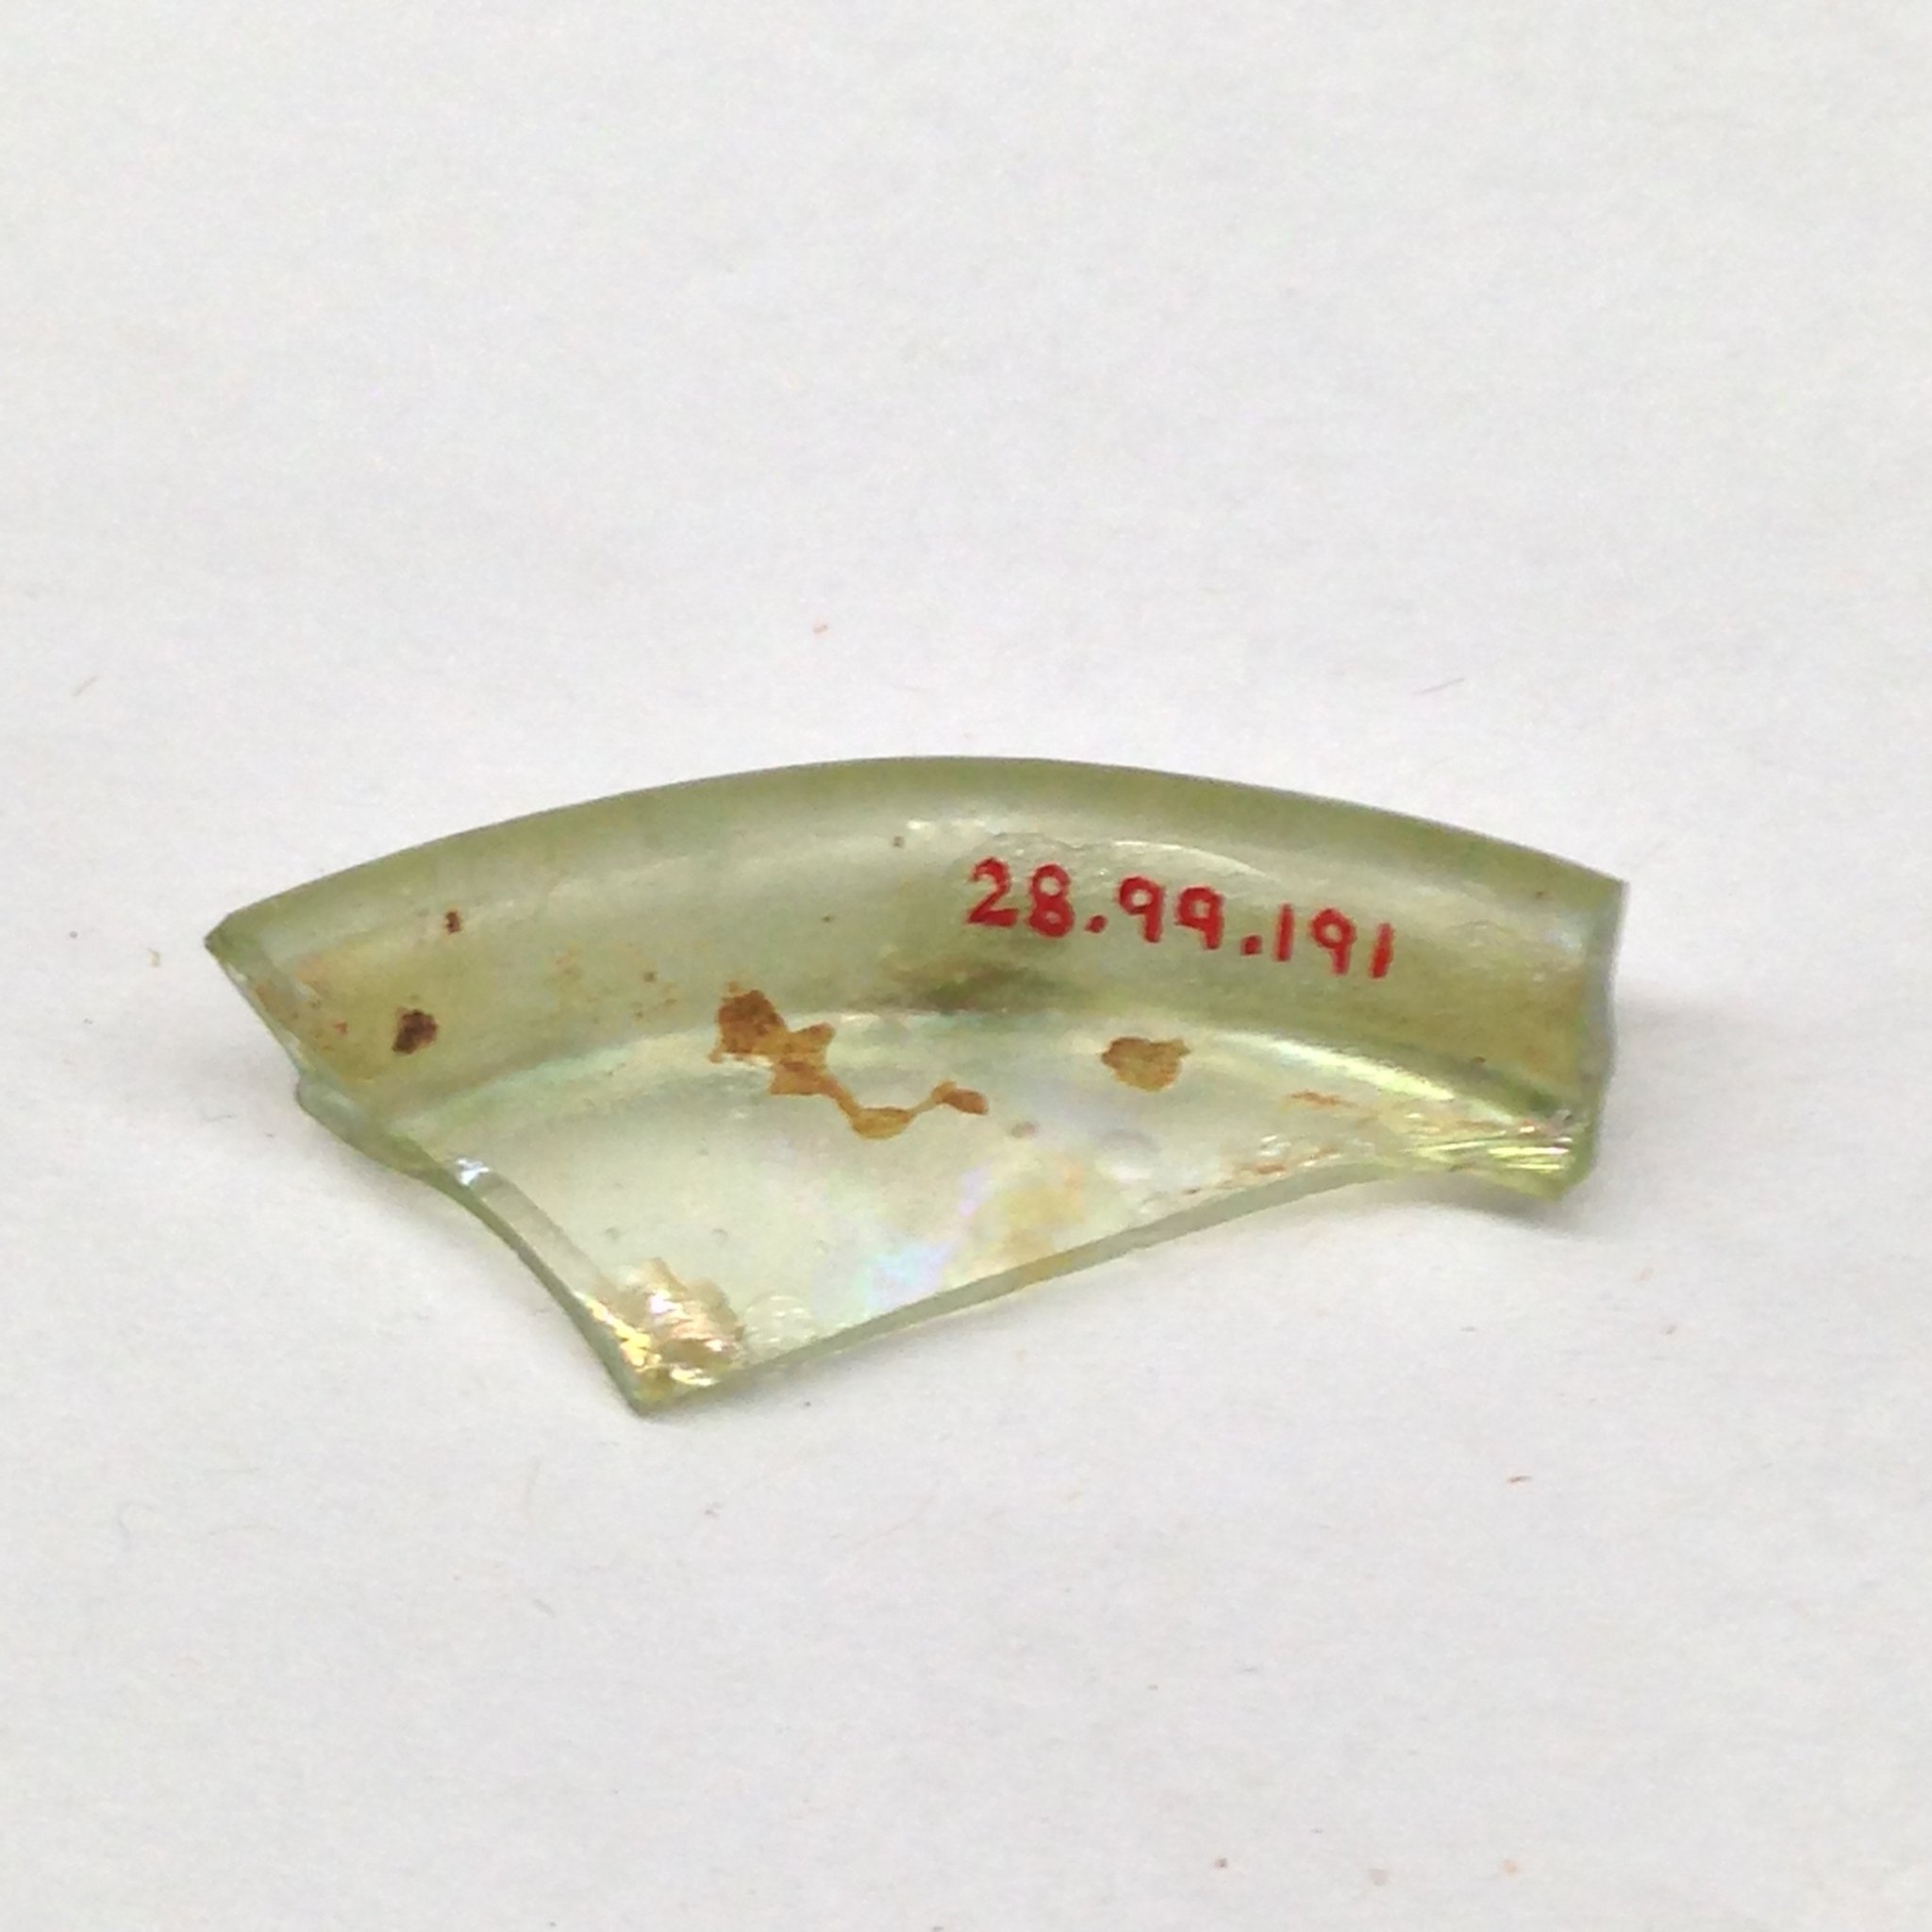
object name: fragment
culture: european or middle eastern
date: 1150-1250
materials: ceramic, glass